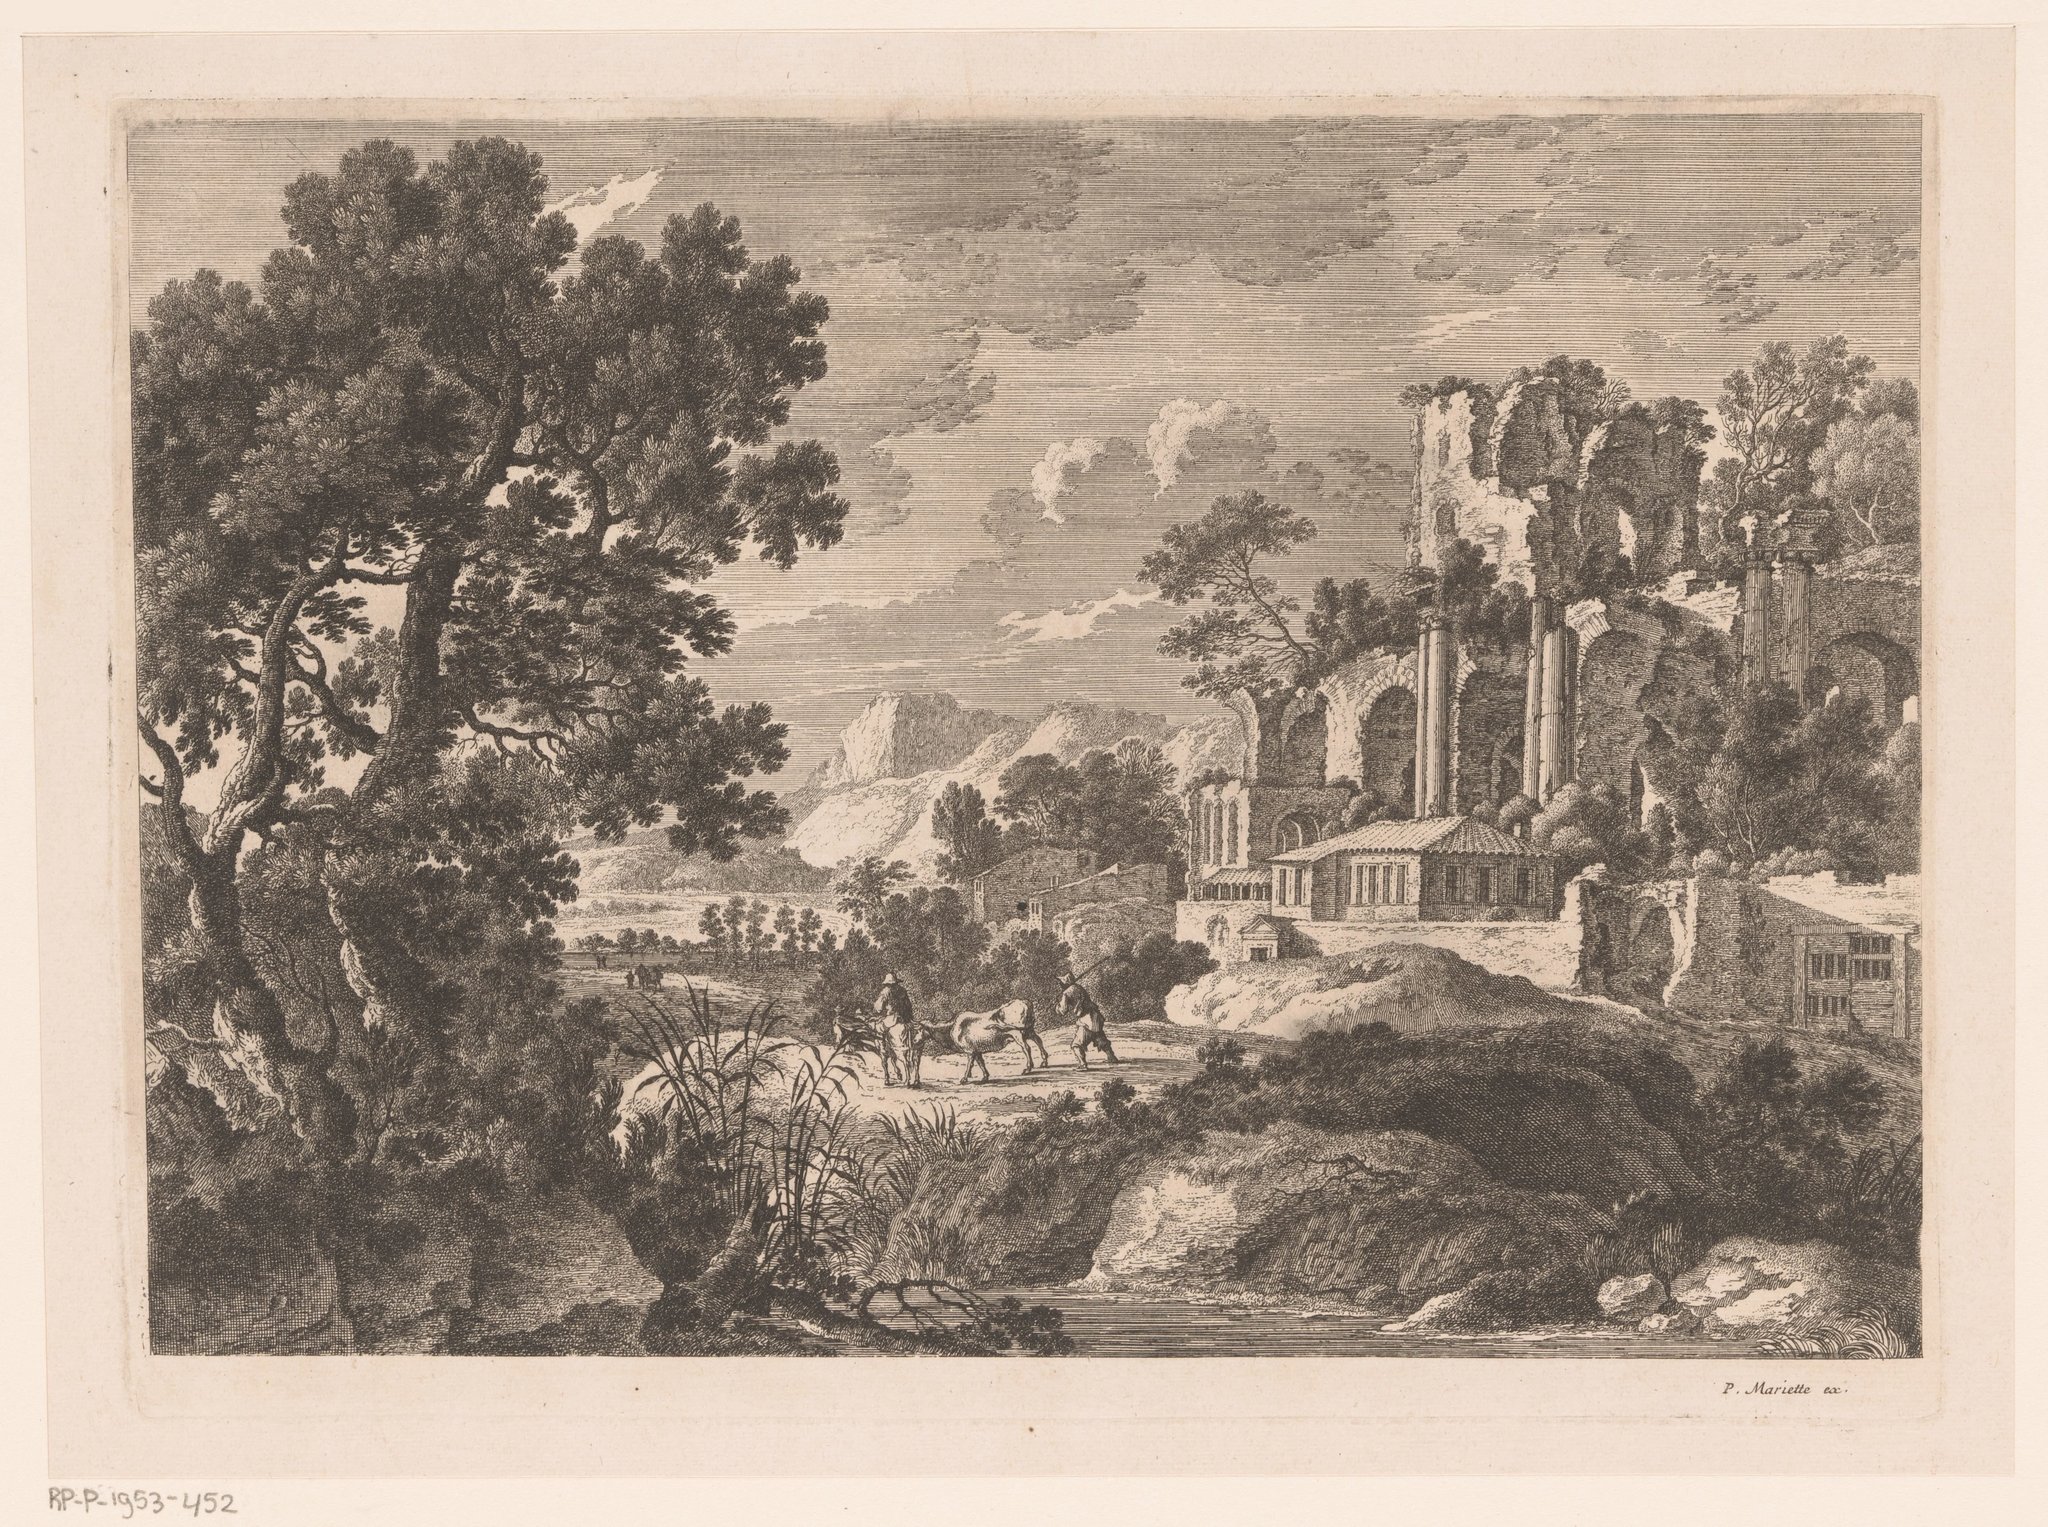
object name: print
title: Landschap met ruiter en koeherder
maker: pierre mariette (ii)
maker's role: publisher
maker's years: 1634-1716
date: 1644-1695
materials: paper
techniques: engraving, etching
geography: paris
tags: landscapes, herding, herdsman, herdswoman, shepherd, shepherdess, cowherd, etc., landscape with ruins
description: Prenten met het signatuur 'Perelle' kunnen zowel door vader Gabriel als door zonen Nicolas en Adam gemaakt zijn.